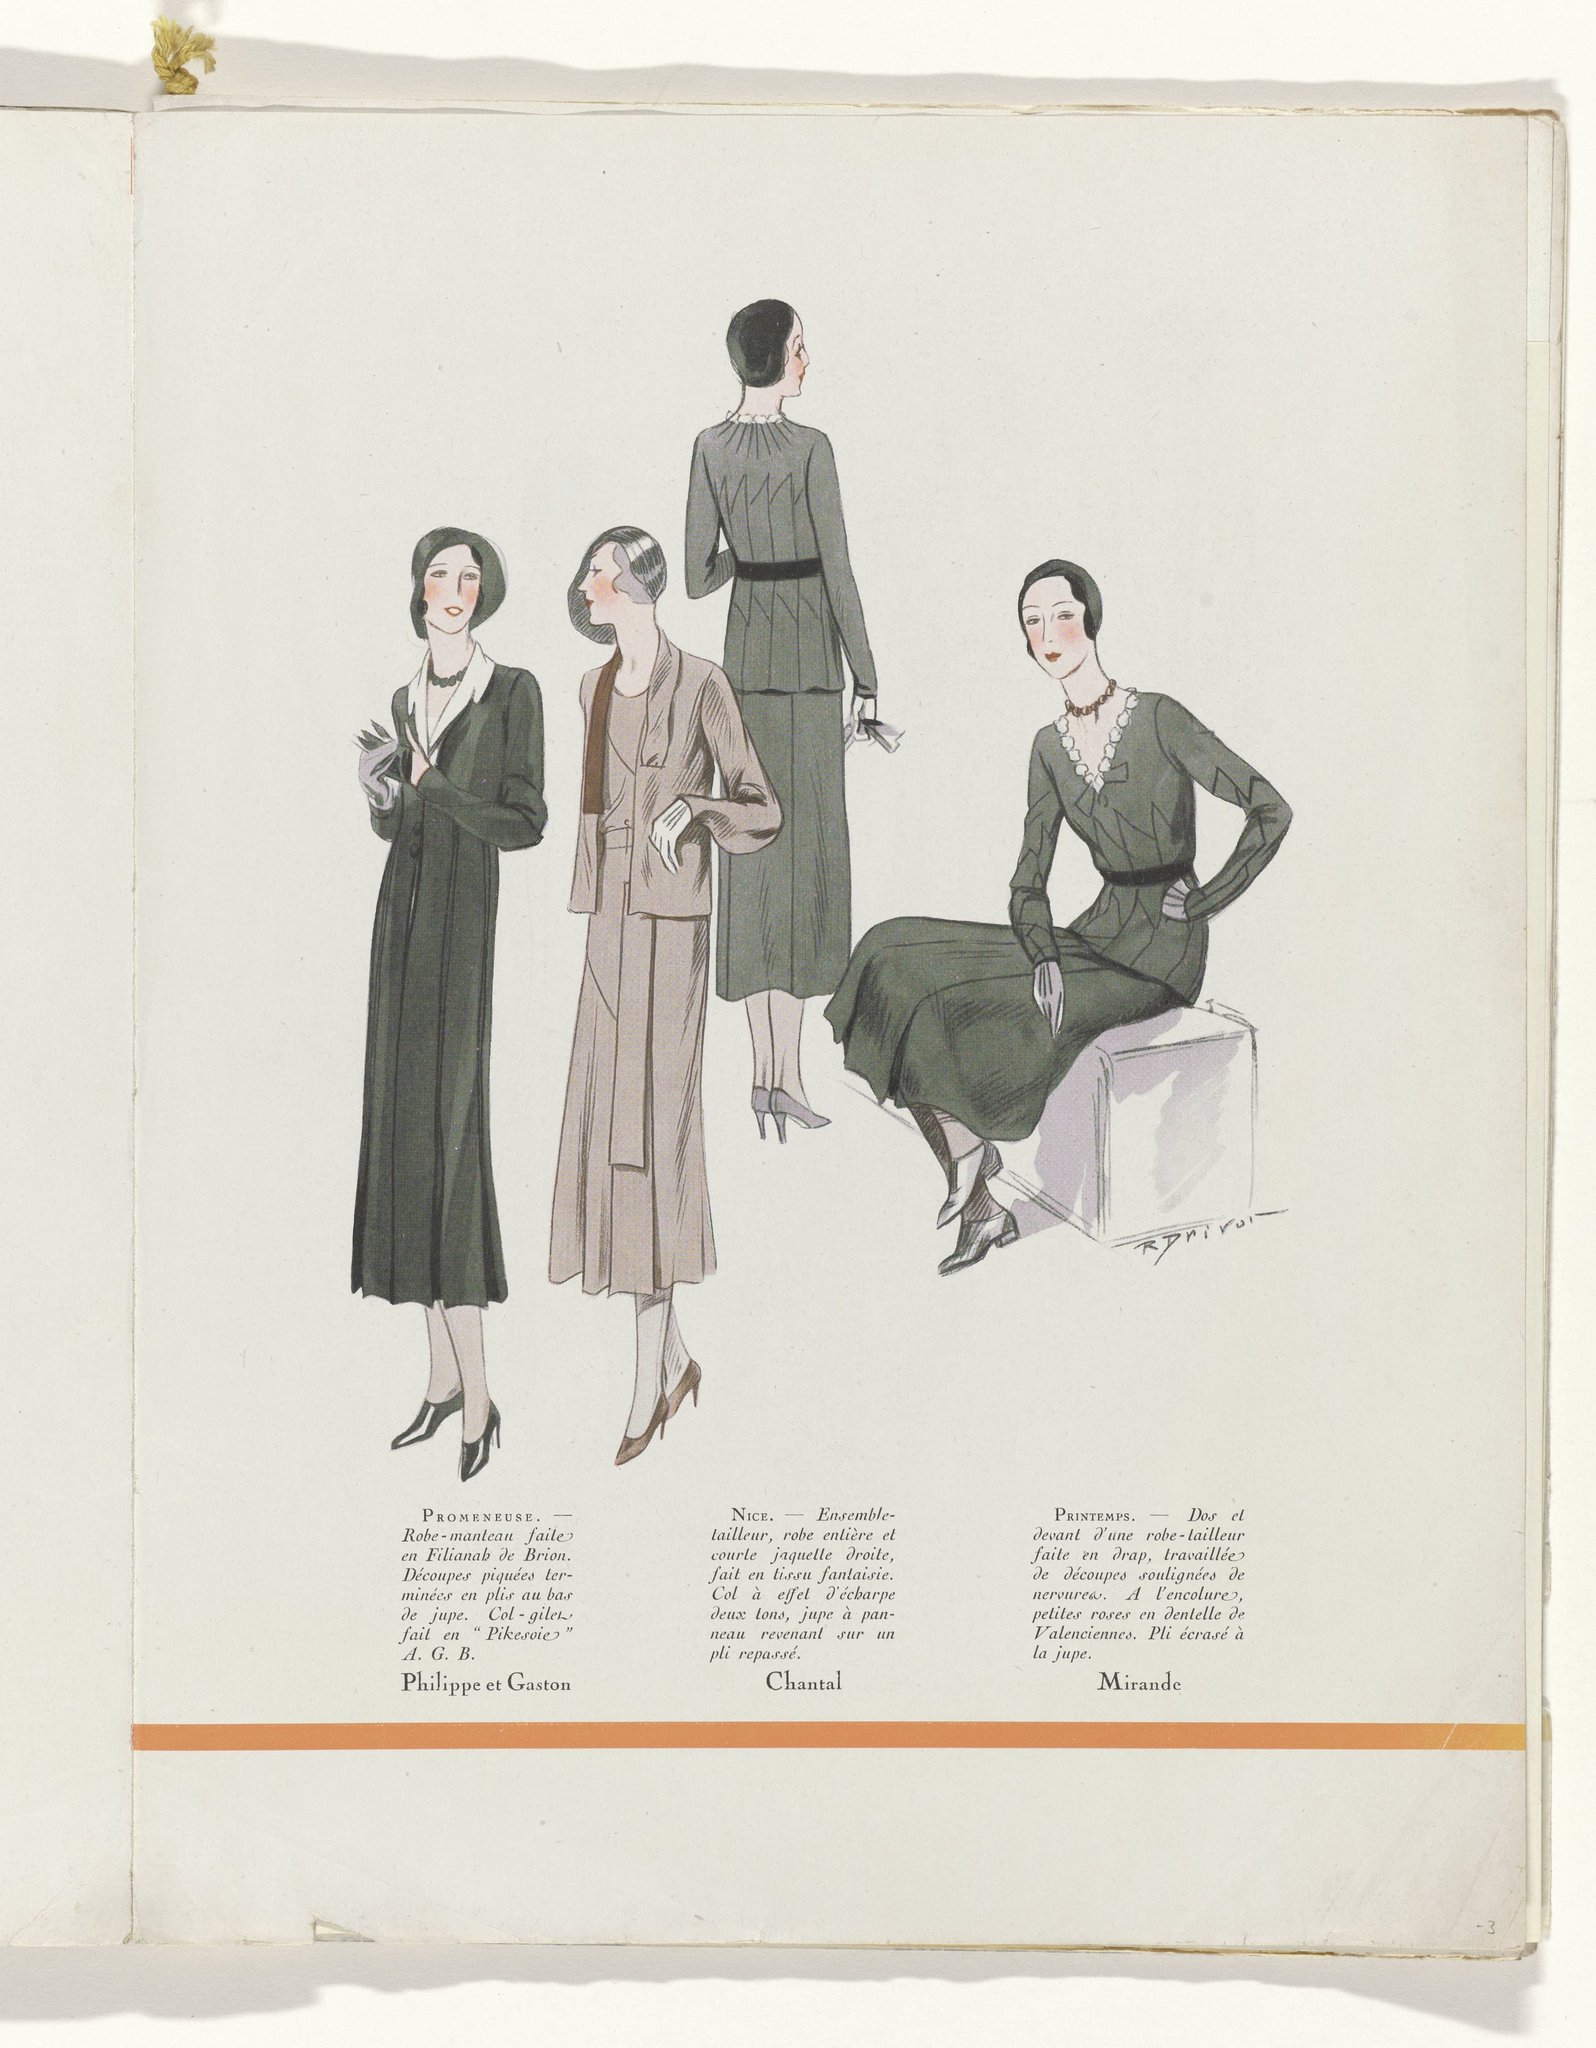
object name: magazine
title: Art - Goût - Beauté, Feuillets de l' élégance féminine, Mai 1931, No. 129, 11e Année, p. 3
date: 1931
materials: paper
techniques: printing, photography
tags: ensembles of pieces of clothing (suit) (+ women's clothes), dress, gown (robe manteau) (+ women's clothes), coat (+ women's clothes), fashion plates, skirt (+ women's clothes), gloves, mittens, etc. (+ women's clothes), dress, gown (+ women's clothes)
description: Links: "Promeneuse": ´robe-manteau´ van Philippe et Gaston. Midden: "Nice": 'Ensemble-Tailleur', bestaande uit een jurk en jasje, van Chantal. Rechts: "Printemps": 'robe-tailleur' van Mirande. Pagina uit het modetijdschrift Art-Goût-Beauté (1920-1933).